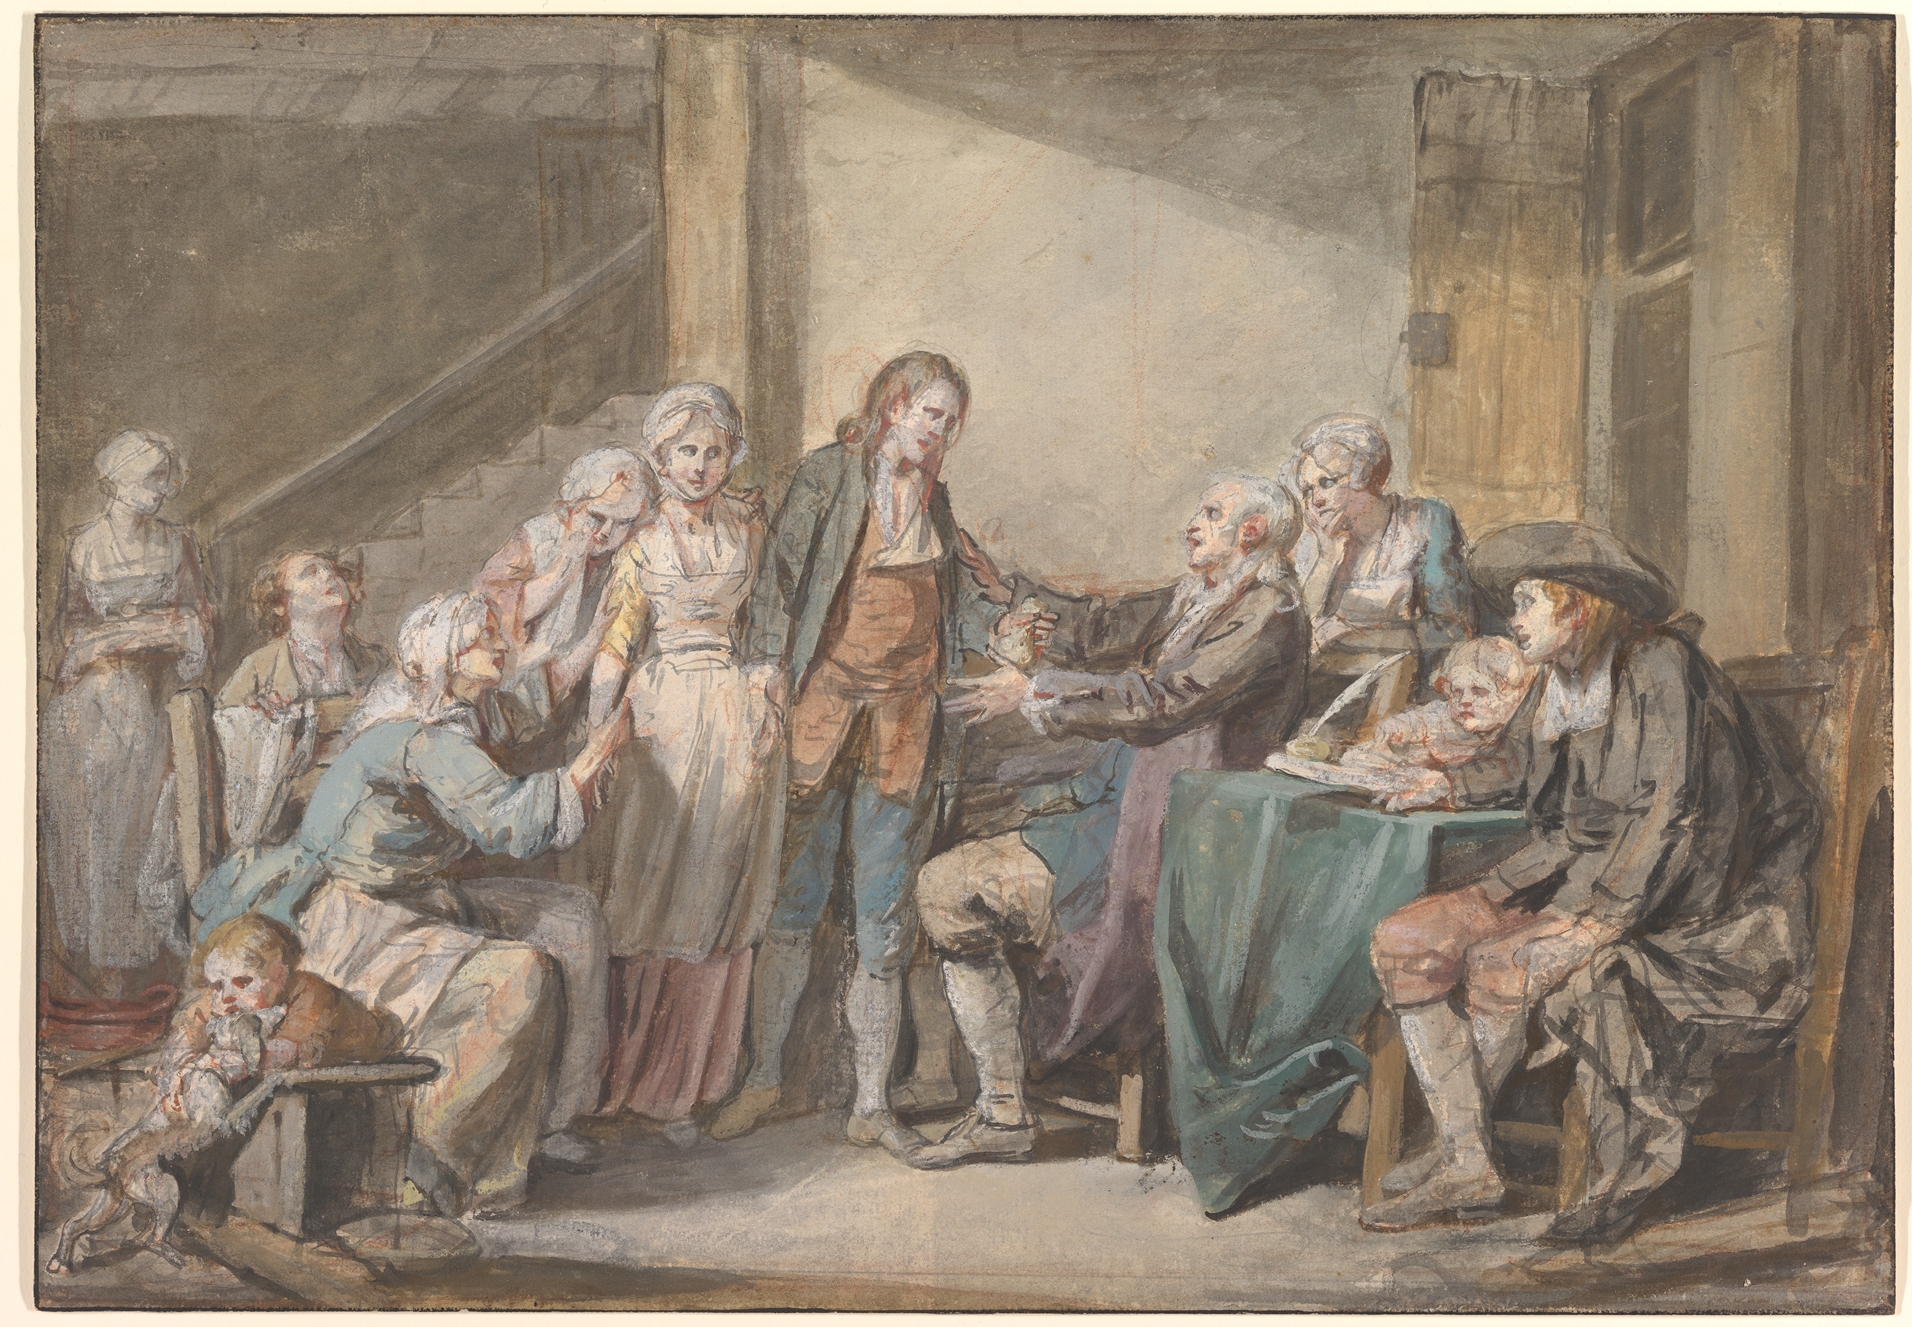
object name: drawing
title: The Marriage Contract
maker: jean-baptiste greuze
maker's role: artist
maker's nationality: french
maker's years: 1725-1805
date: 1761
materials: chalk, gouache, graphite, watercolor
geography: france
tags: children,men,women,dogs